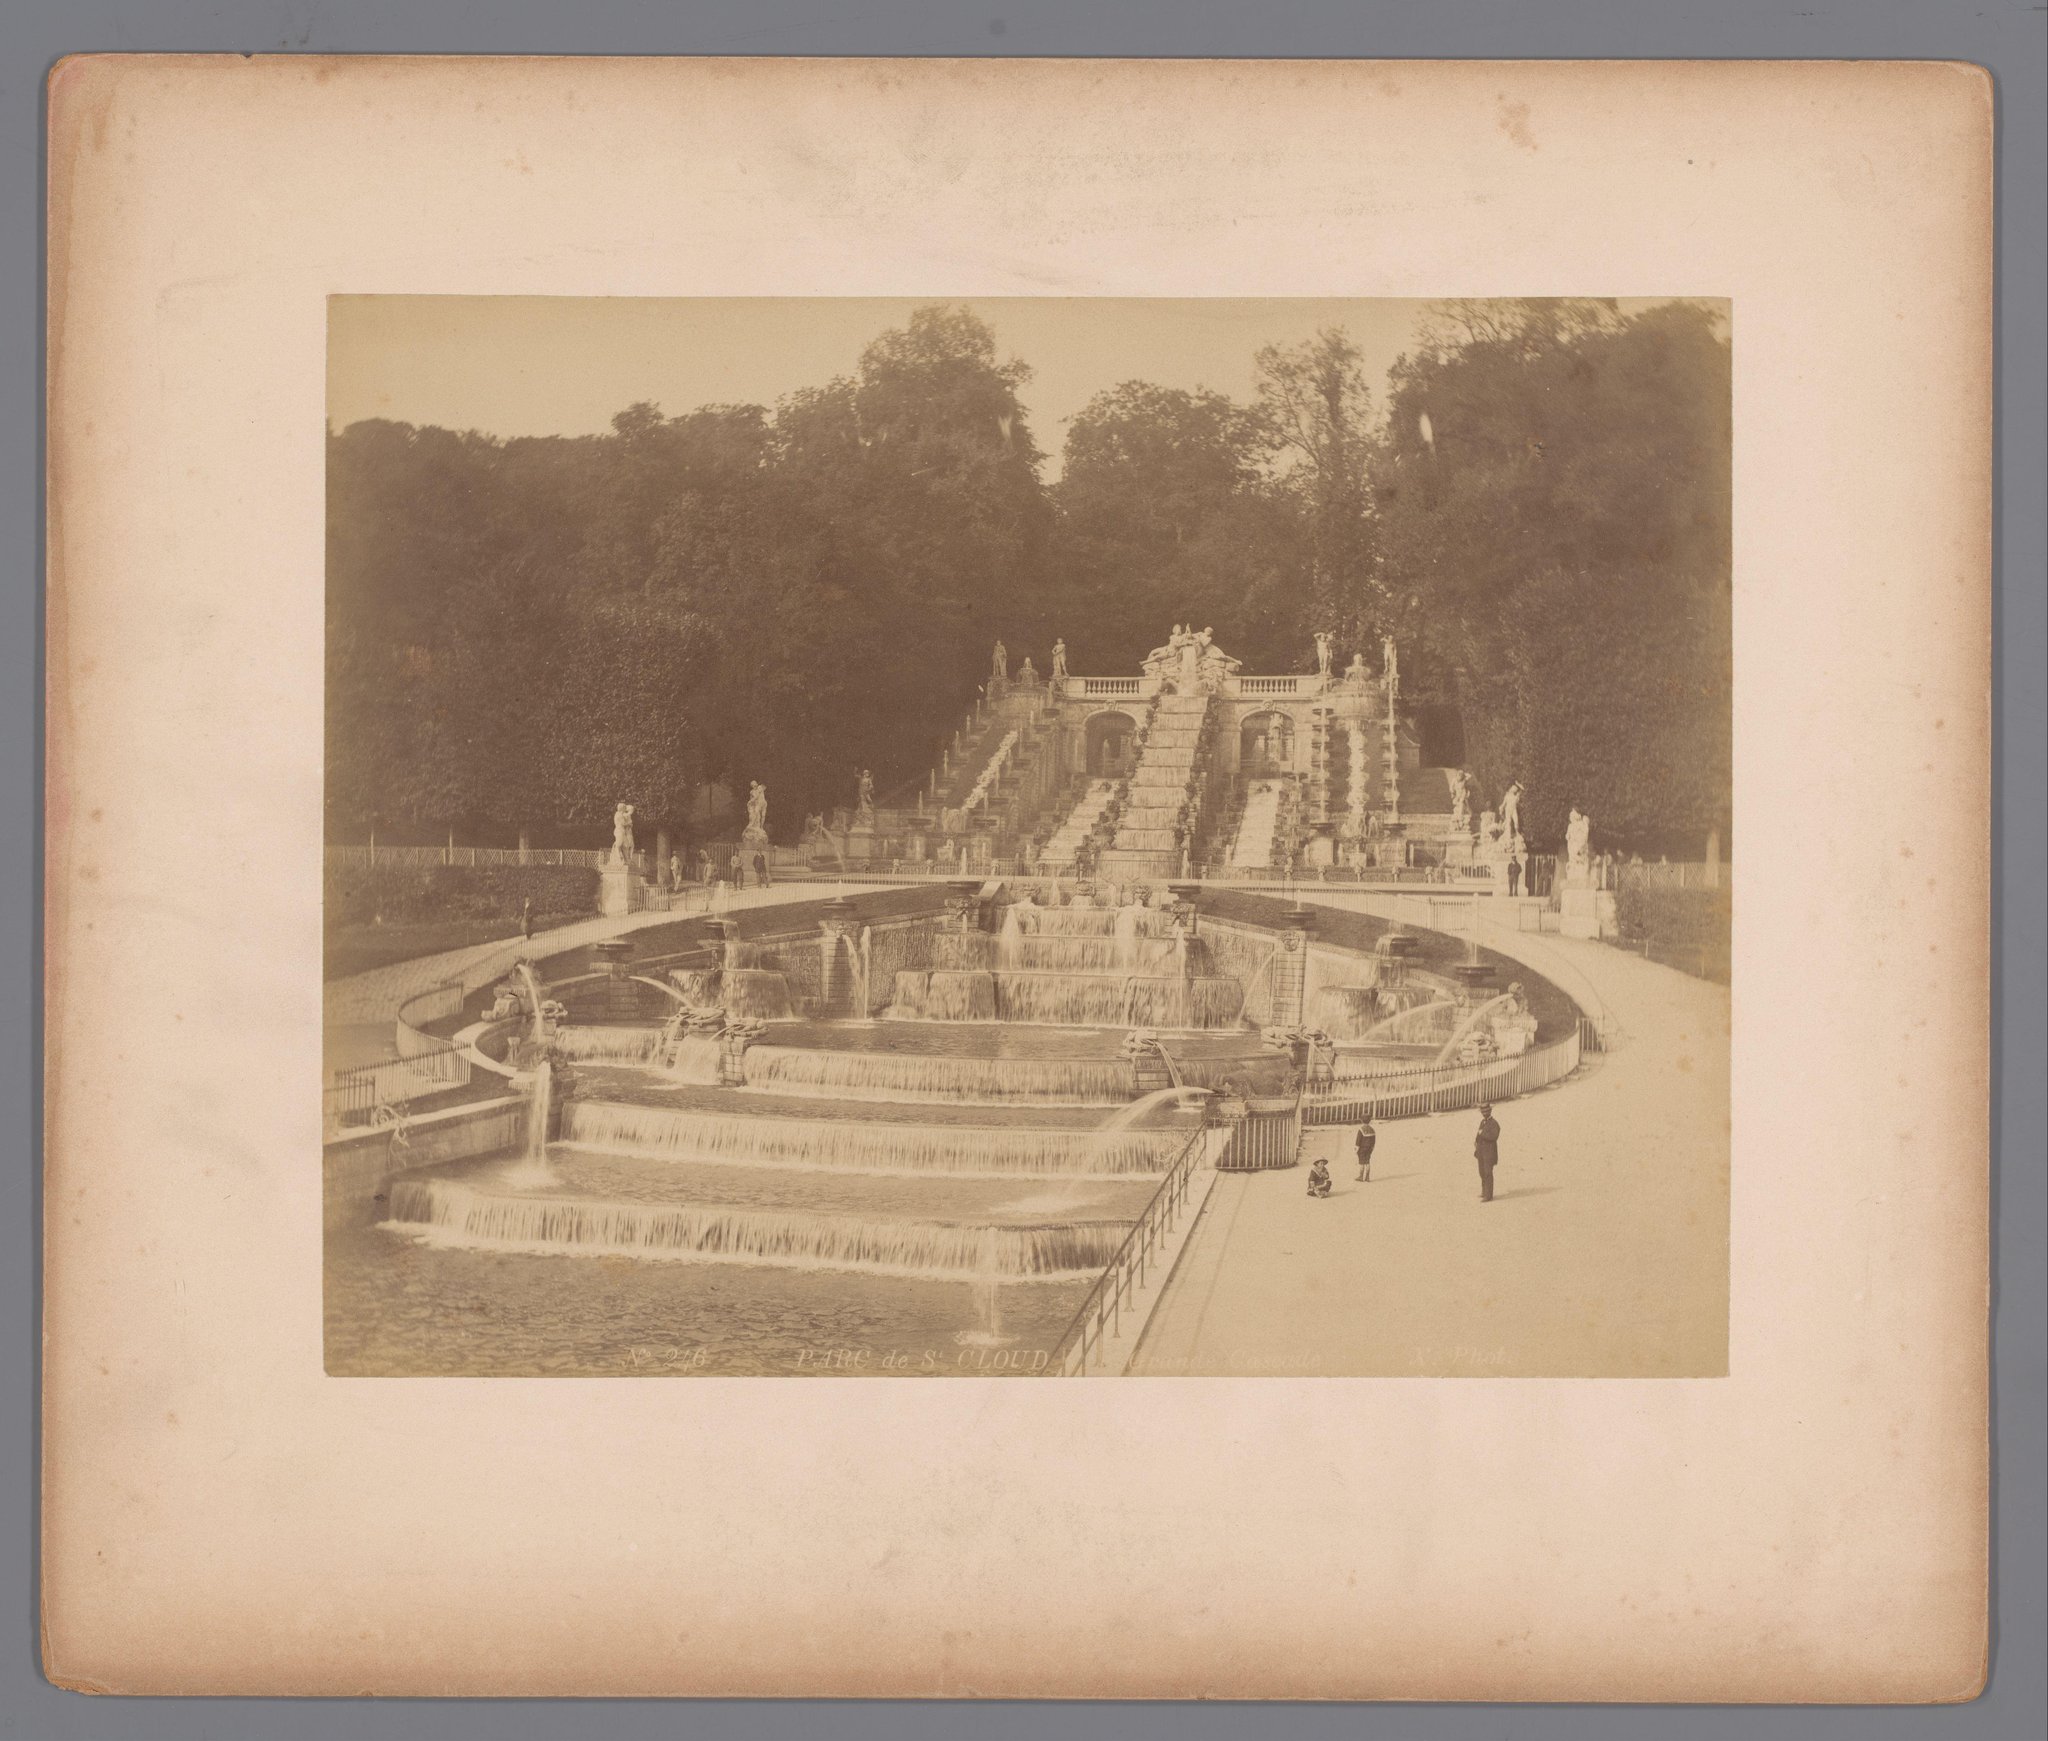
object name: photograph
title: "Parc de St. Cloud, La Grande Cascade", Parijs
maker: j. kühn (uitgever)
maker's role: publisher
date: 1880-1900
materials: cardboard, paper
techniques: albumen print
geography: paris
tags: paris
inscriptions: signature: ‘X. Phot.’, inscription: ‘No. 247 PARC de St. Cloud La Grande Cascade’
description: Gezicht op een lange symmetrisch aangelegde vijver met fonteinen en enkele mensen, Parijs, Frankrijk.